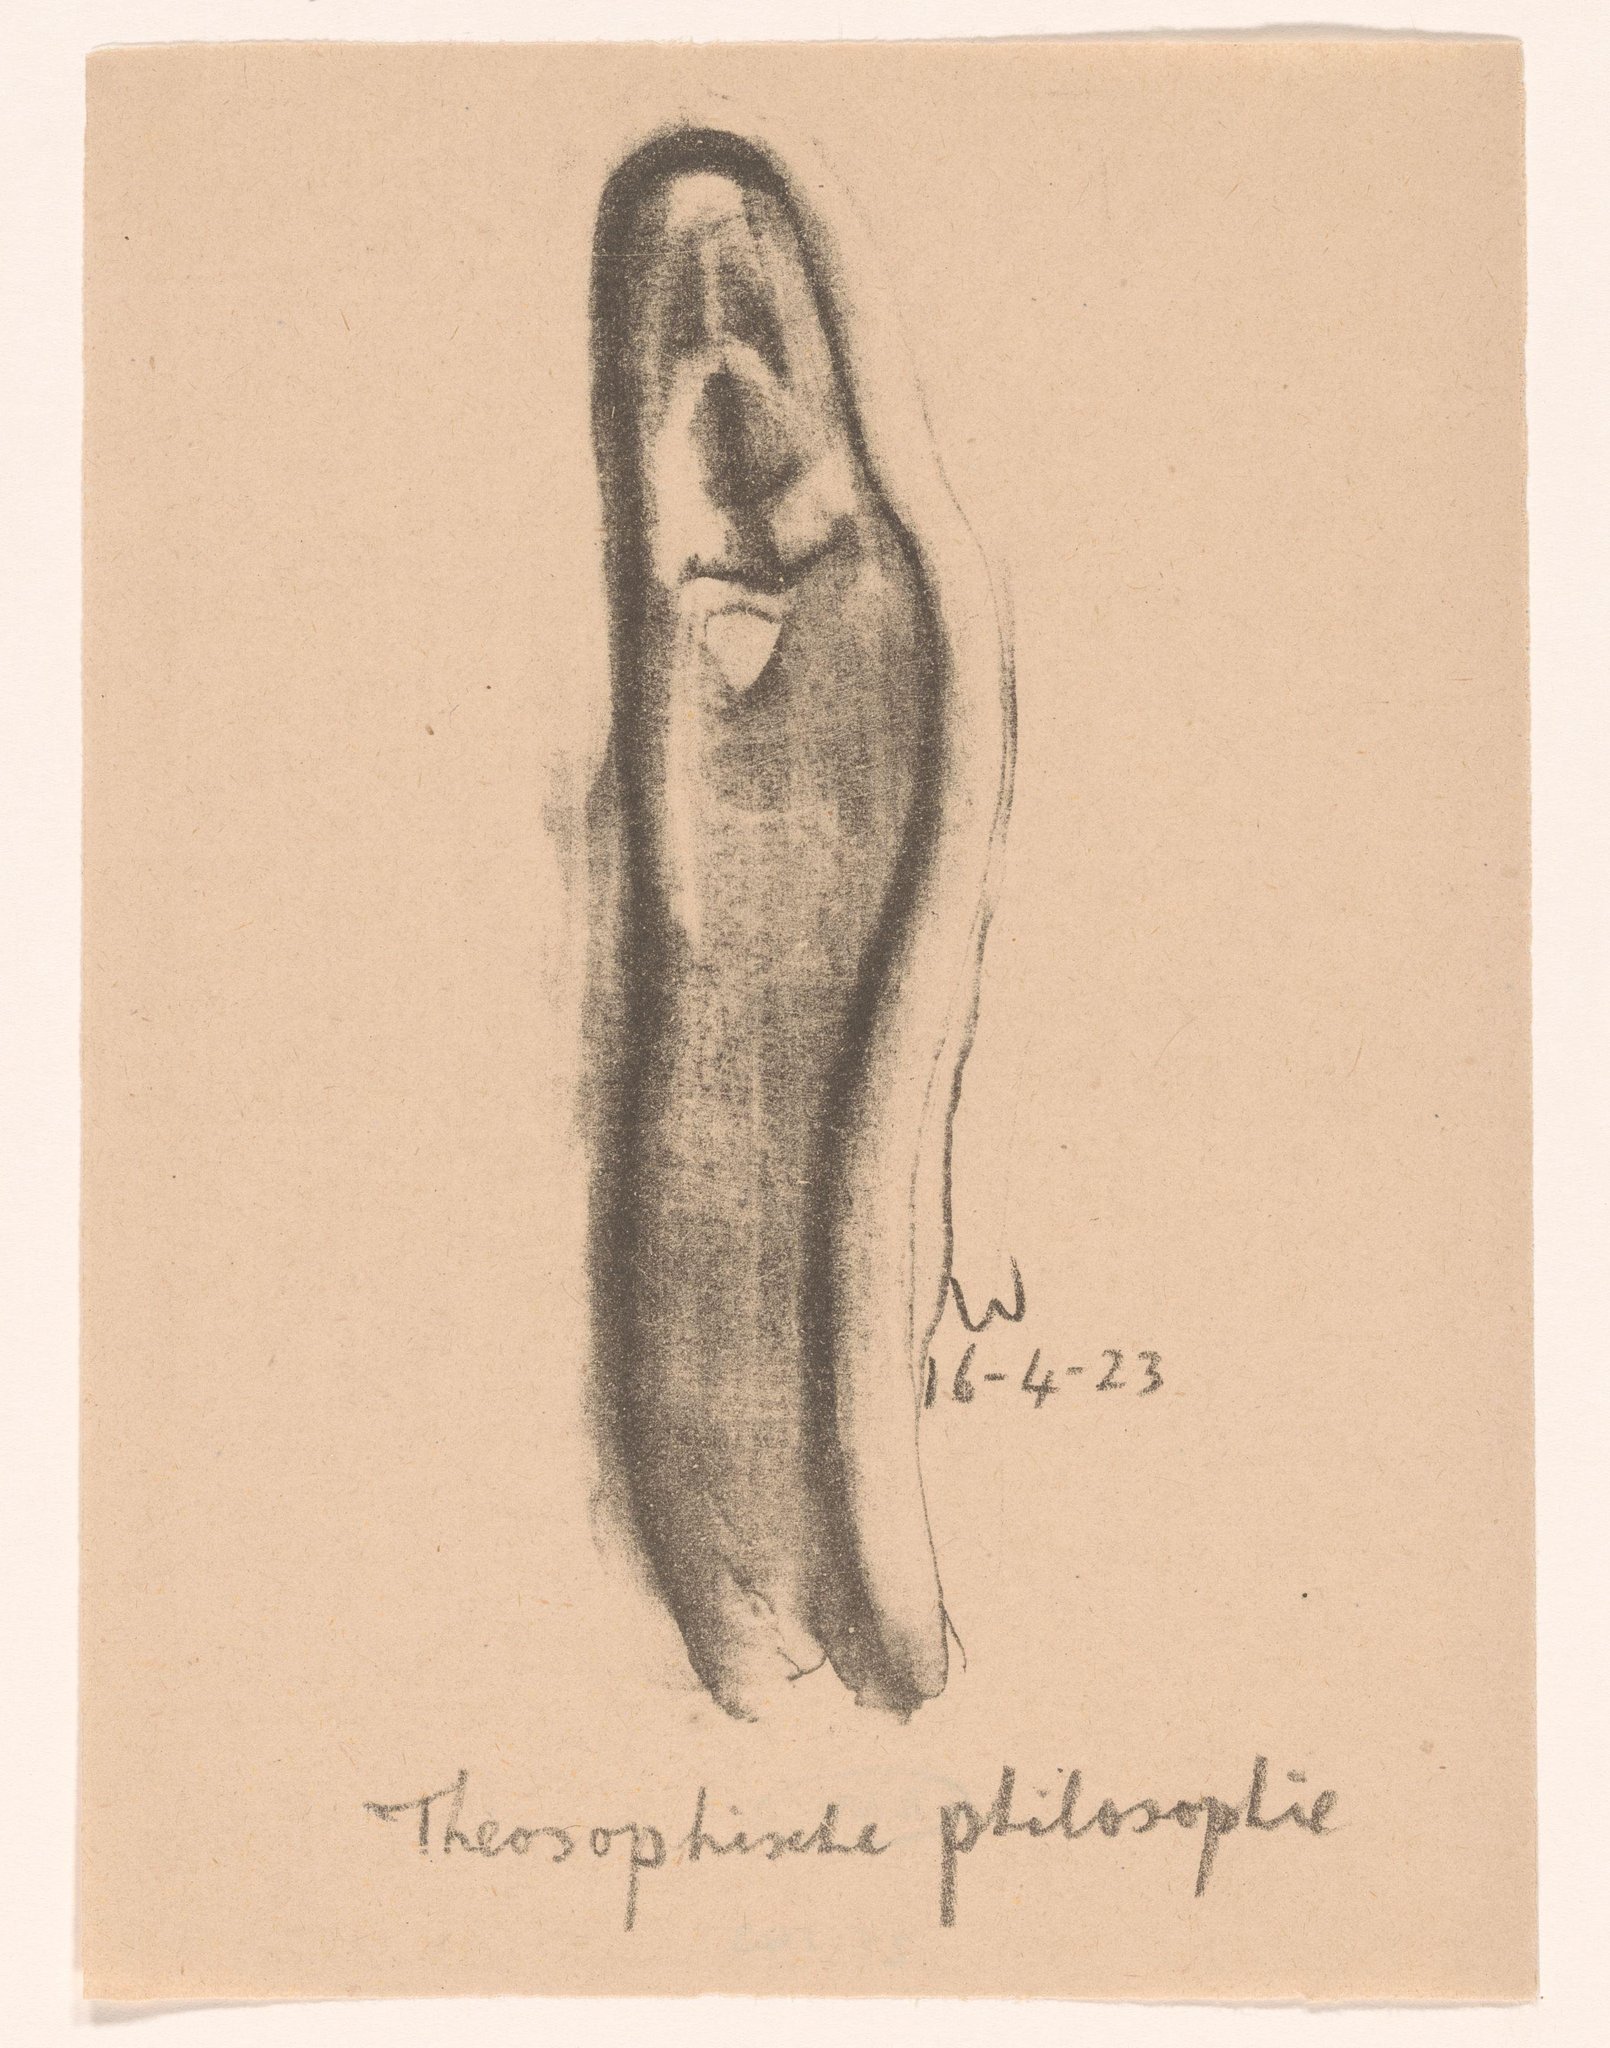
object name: print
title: Idealisten II en verdere Kanttekeningen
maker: erich wichmann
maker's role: print maker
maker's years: 1890-1929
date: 1923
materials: paper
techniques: lithograph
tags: caricatures (human types), miscellaneous religions, cults and doctrines: theosophy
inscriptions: collector's mark: Lugt 2228